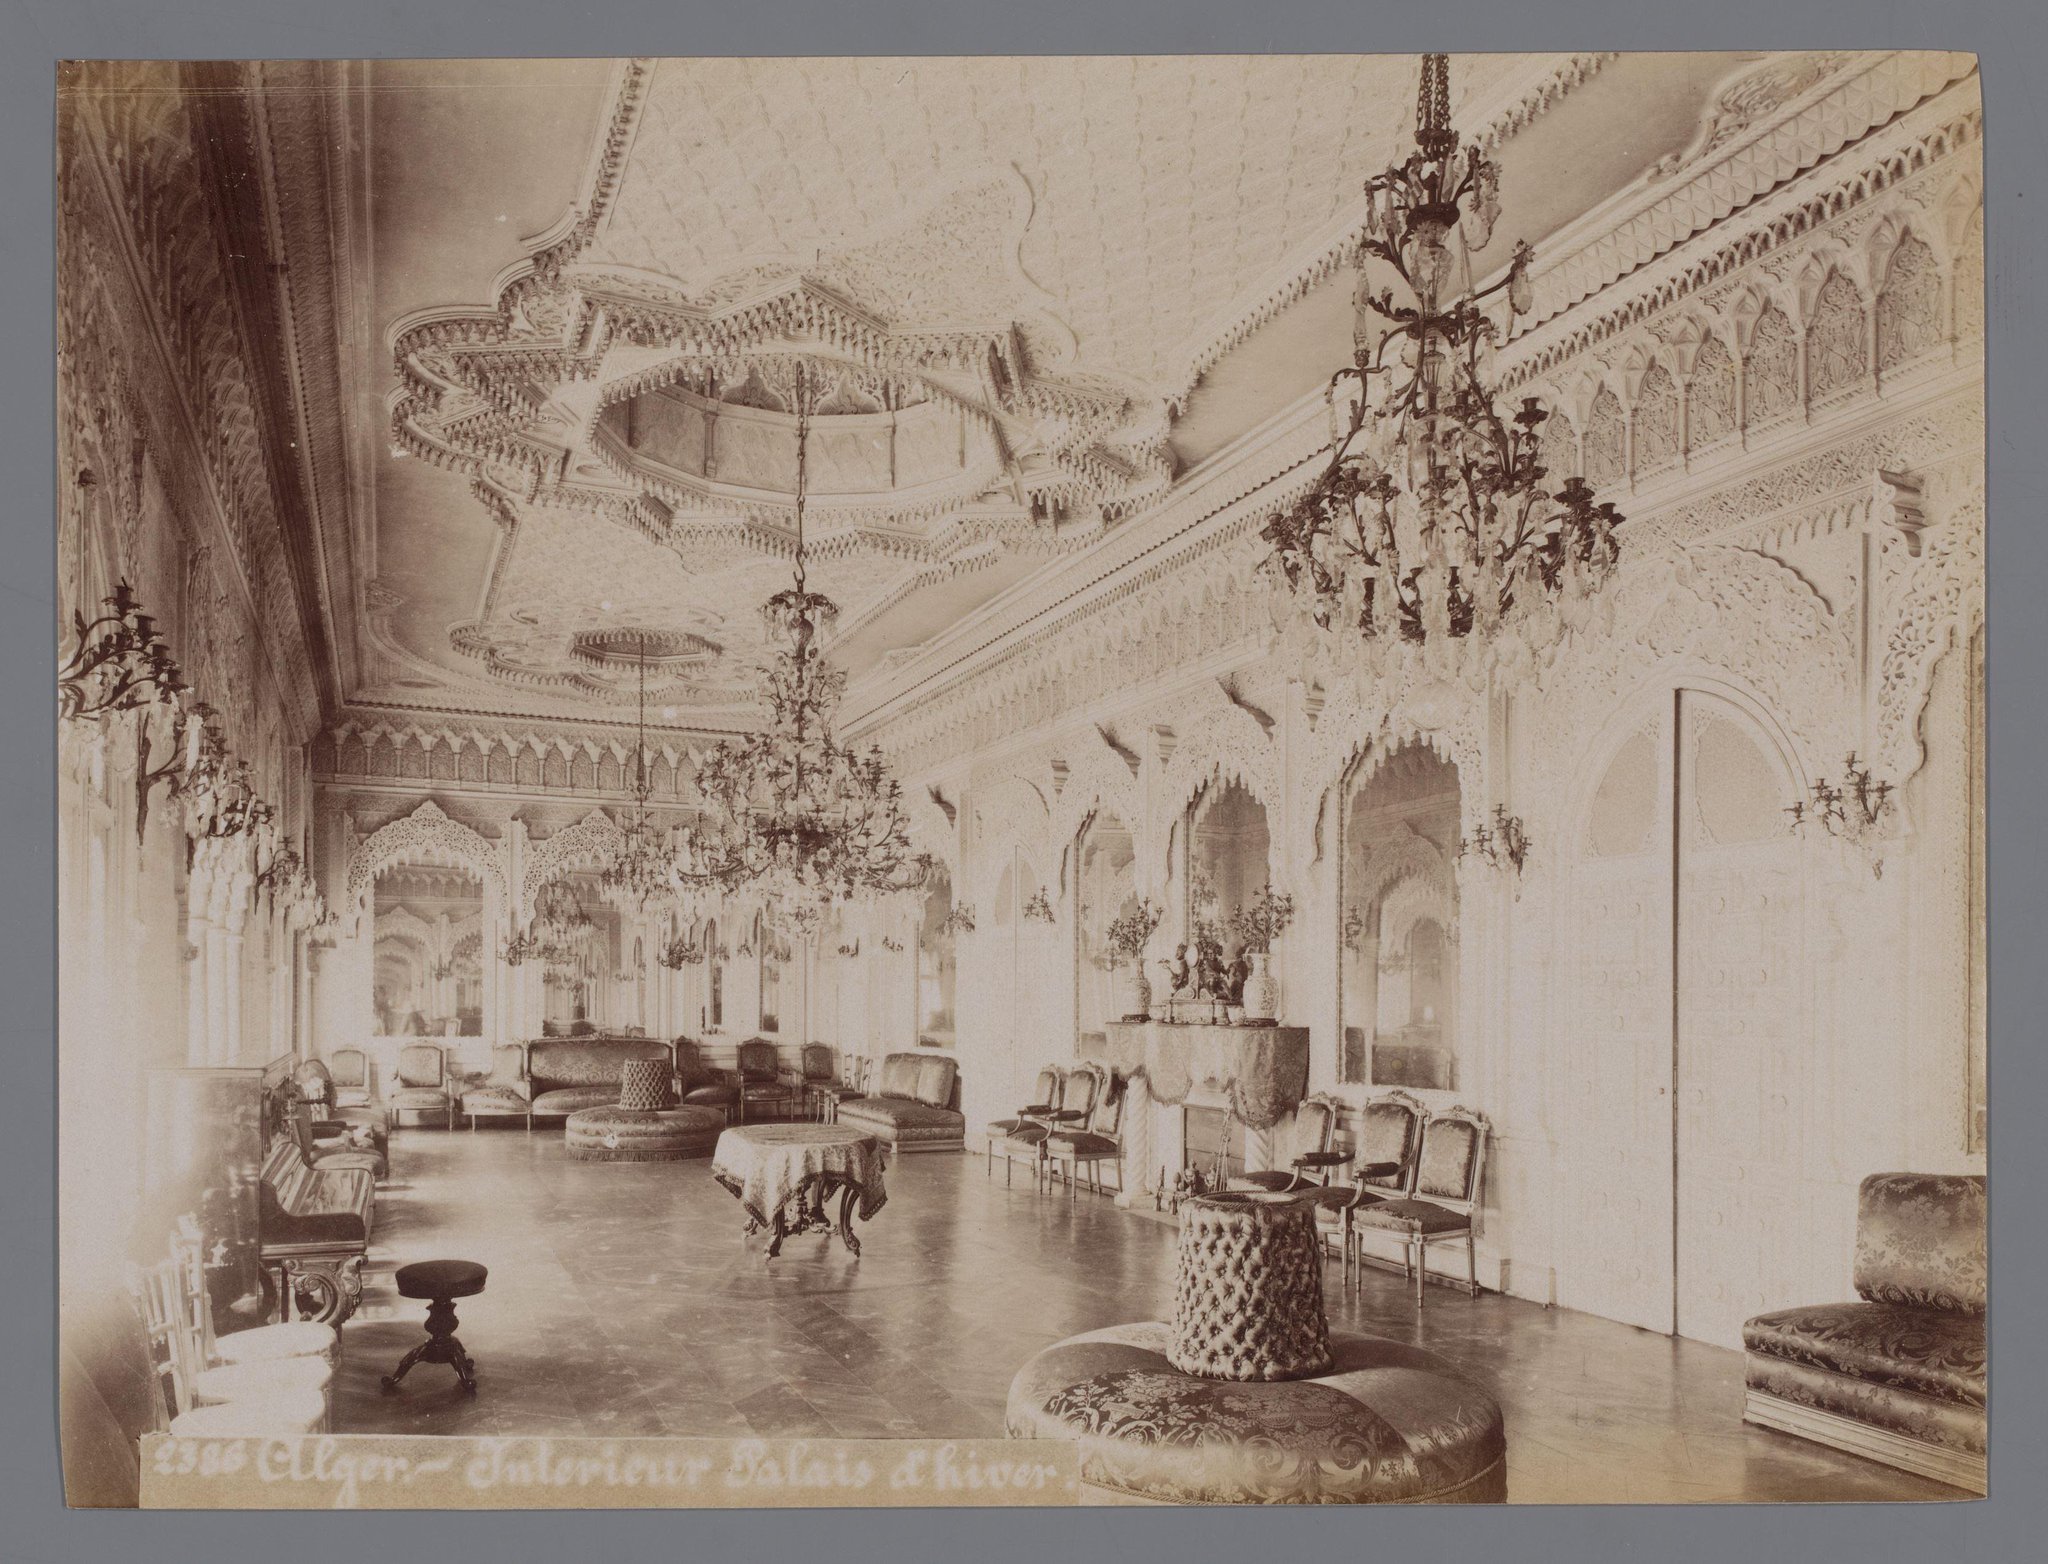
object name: photograph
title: Alger, interieur Palais d'hiver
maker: Anonymous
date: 1860-1900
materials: paper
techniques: albumen print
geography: casbah of algiers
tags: palace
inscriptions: number: ‘2386’